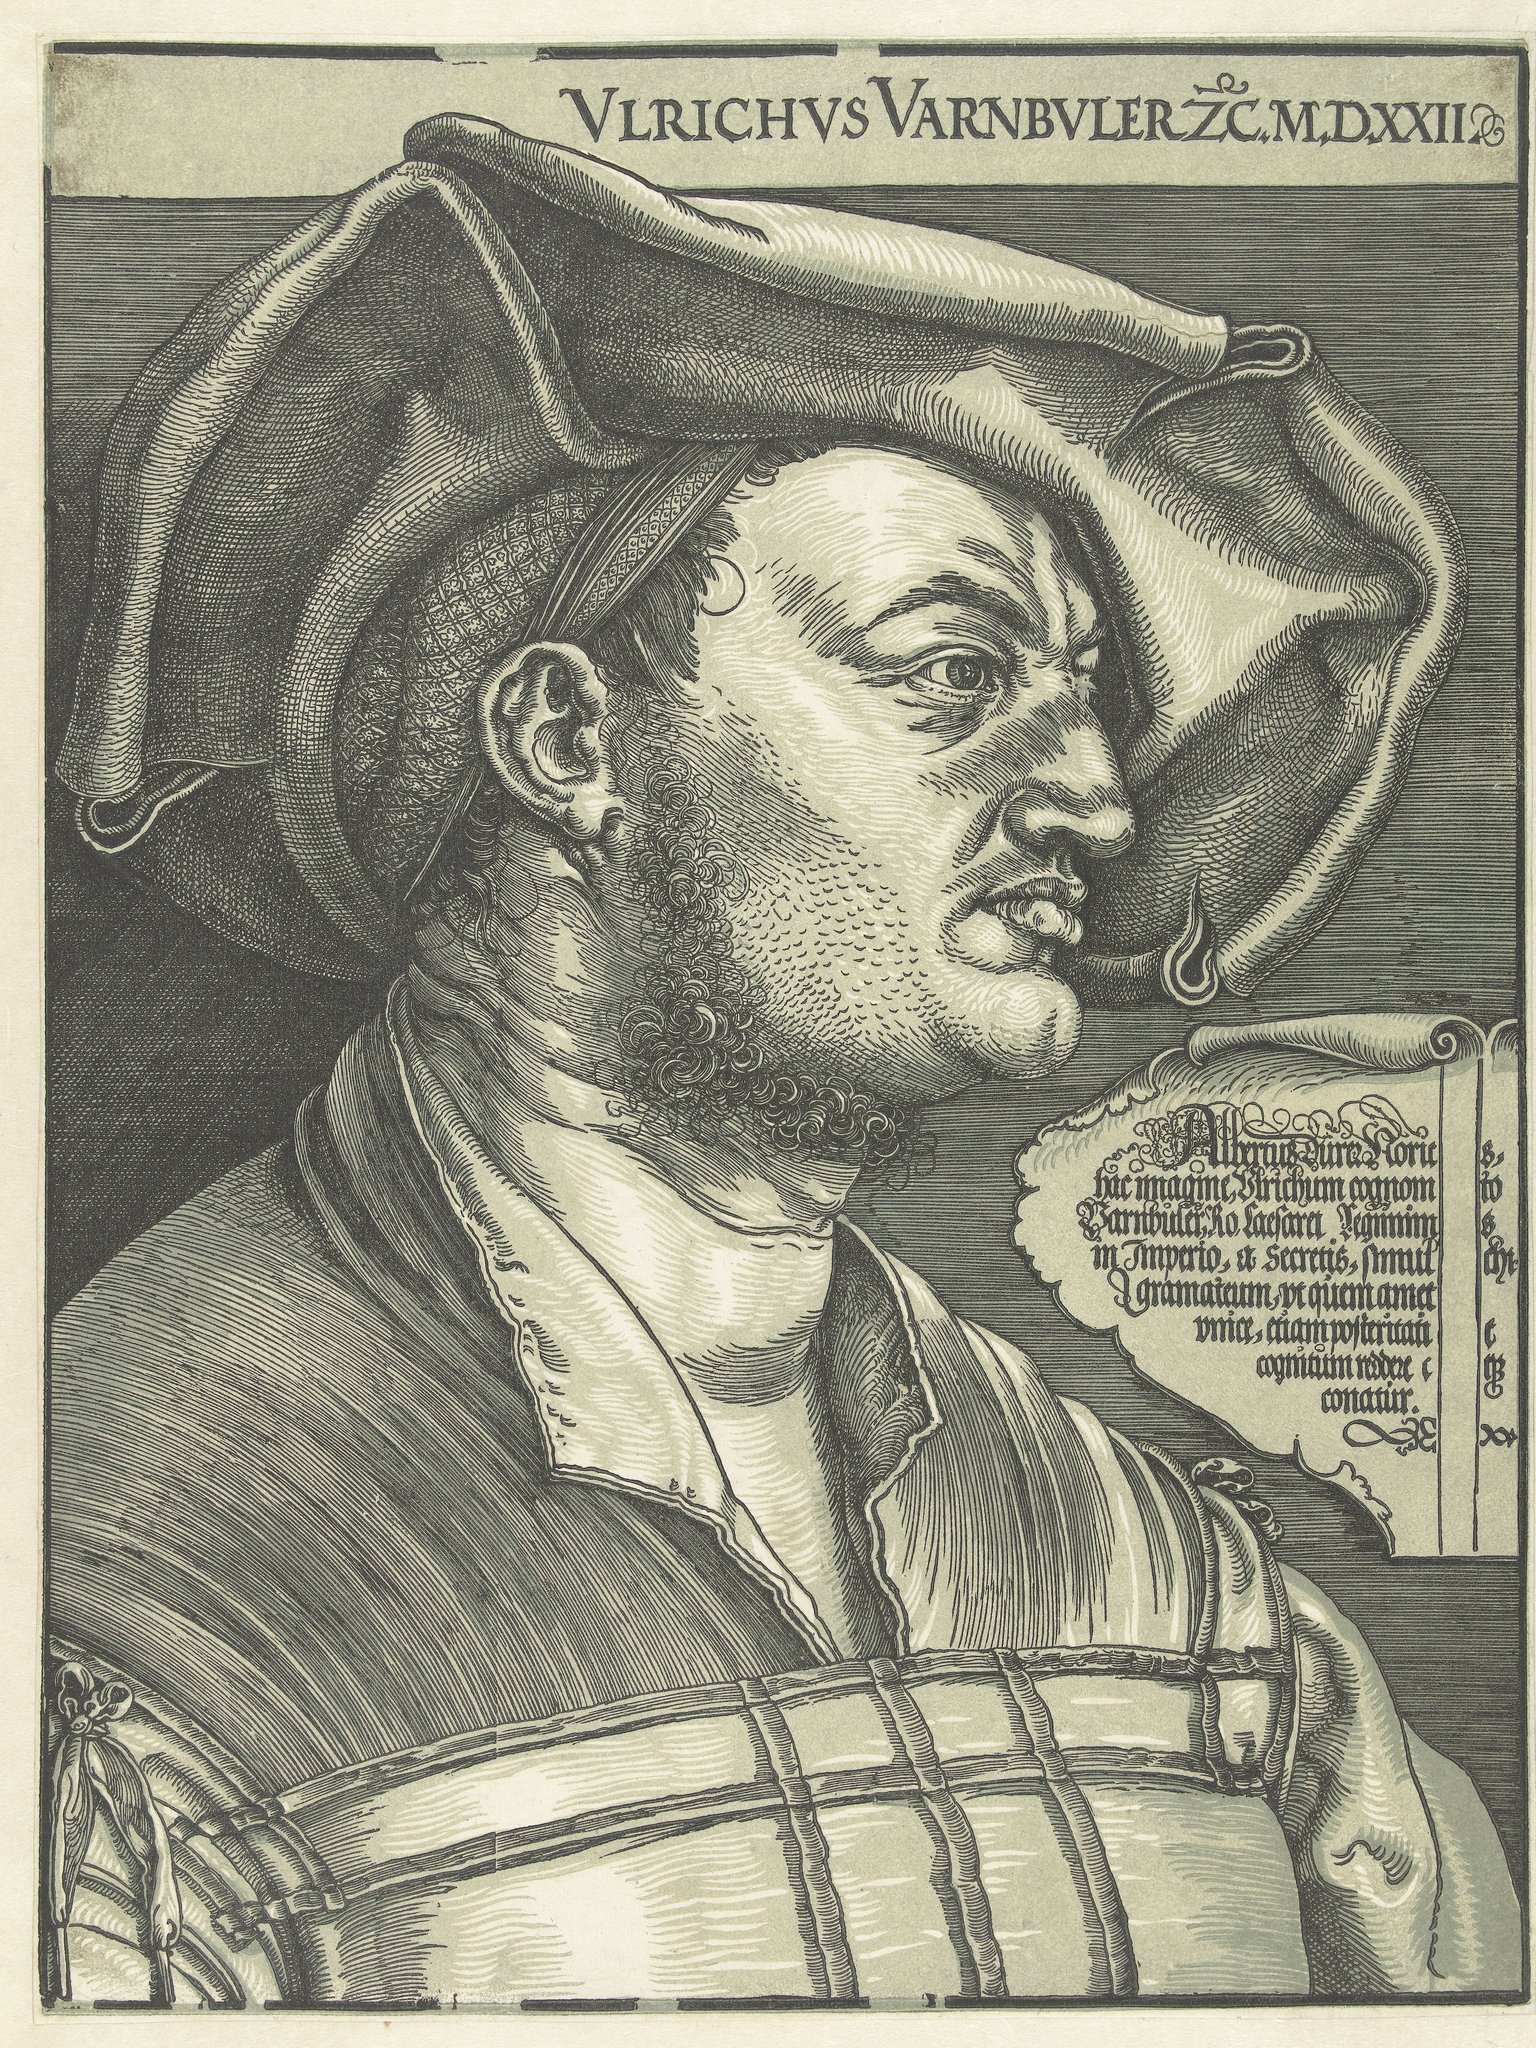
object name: print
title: Portret van Ulrich Varnbüler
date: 1522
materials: paper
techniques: woodcut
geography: nuremberg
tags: mayor, historical persons, head-gear: hat (+ men's clothes)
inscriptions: collector's mark: Lugt 240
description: Portret van Ulrich Varnbüler (1471-ca. 1544), naar rechts gewend, met grote hoed op. Bovenin een opschrift met de naam van de geportretteerde. Rechts naast Varnbülers gezicht een cartouche met de mededeling dat Albrecht Dürer dit portret maakte om Varnbüler te eren.